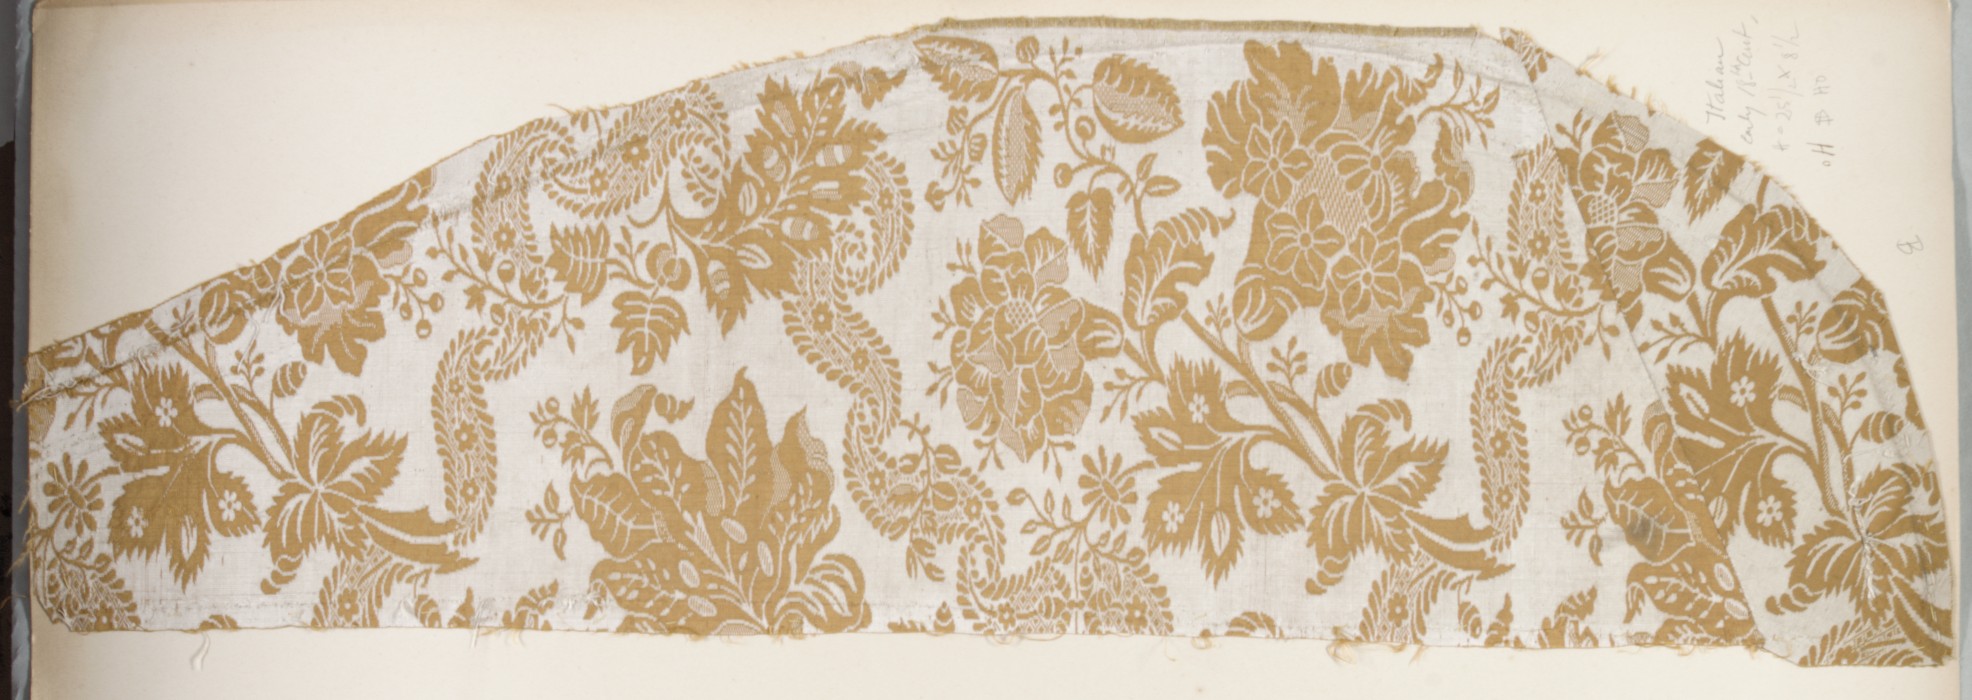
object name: fragment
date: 1701-1800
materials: silk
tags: flowers,leaves